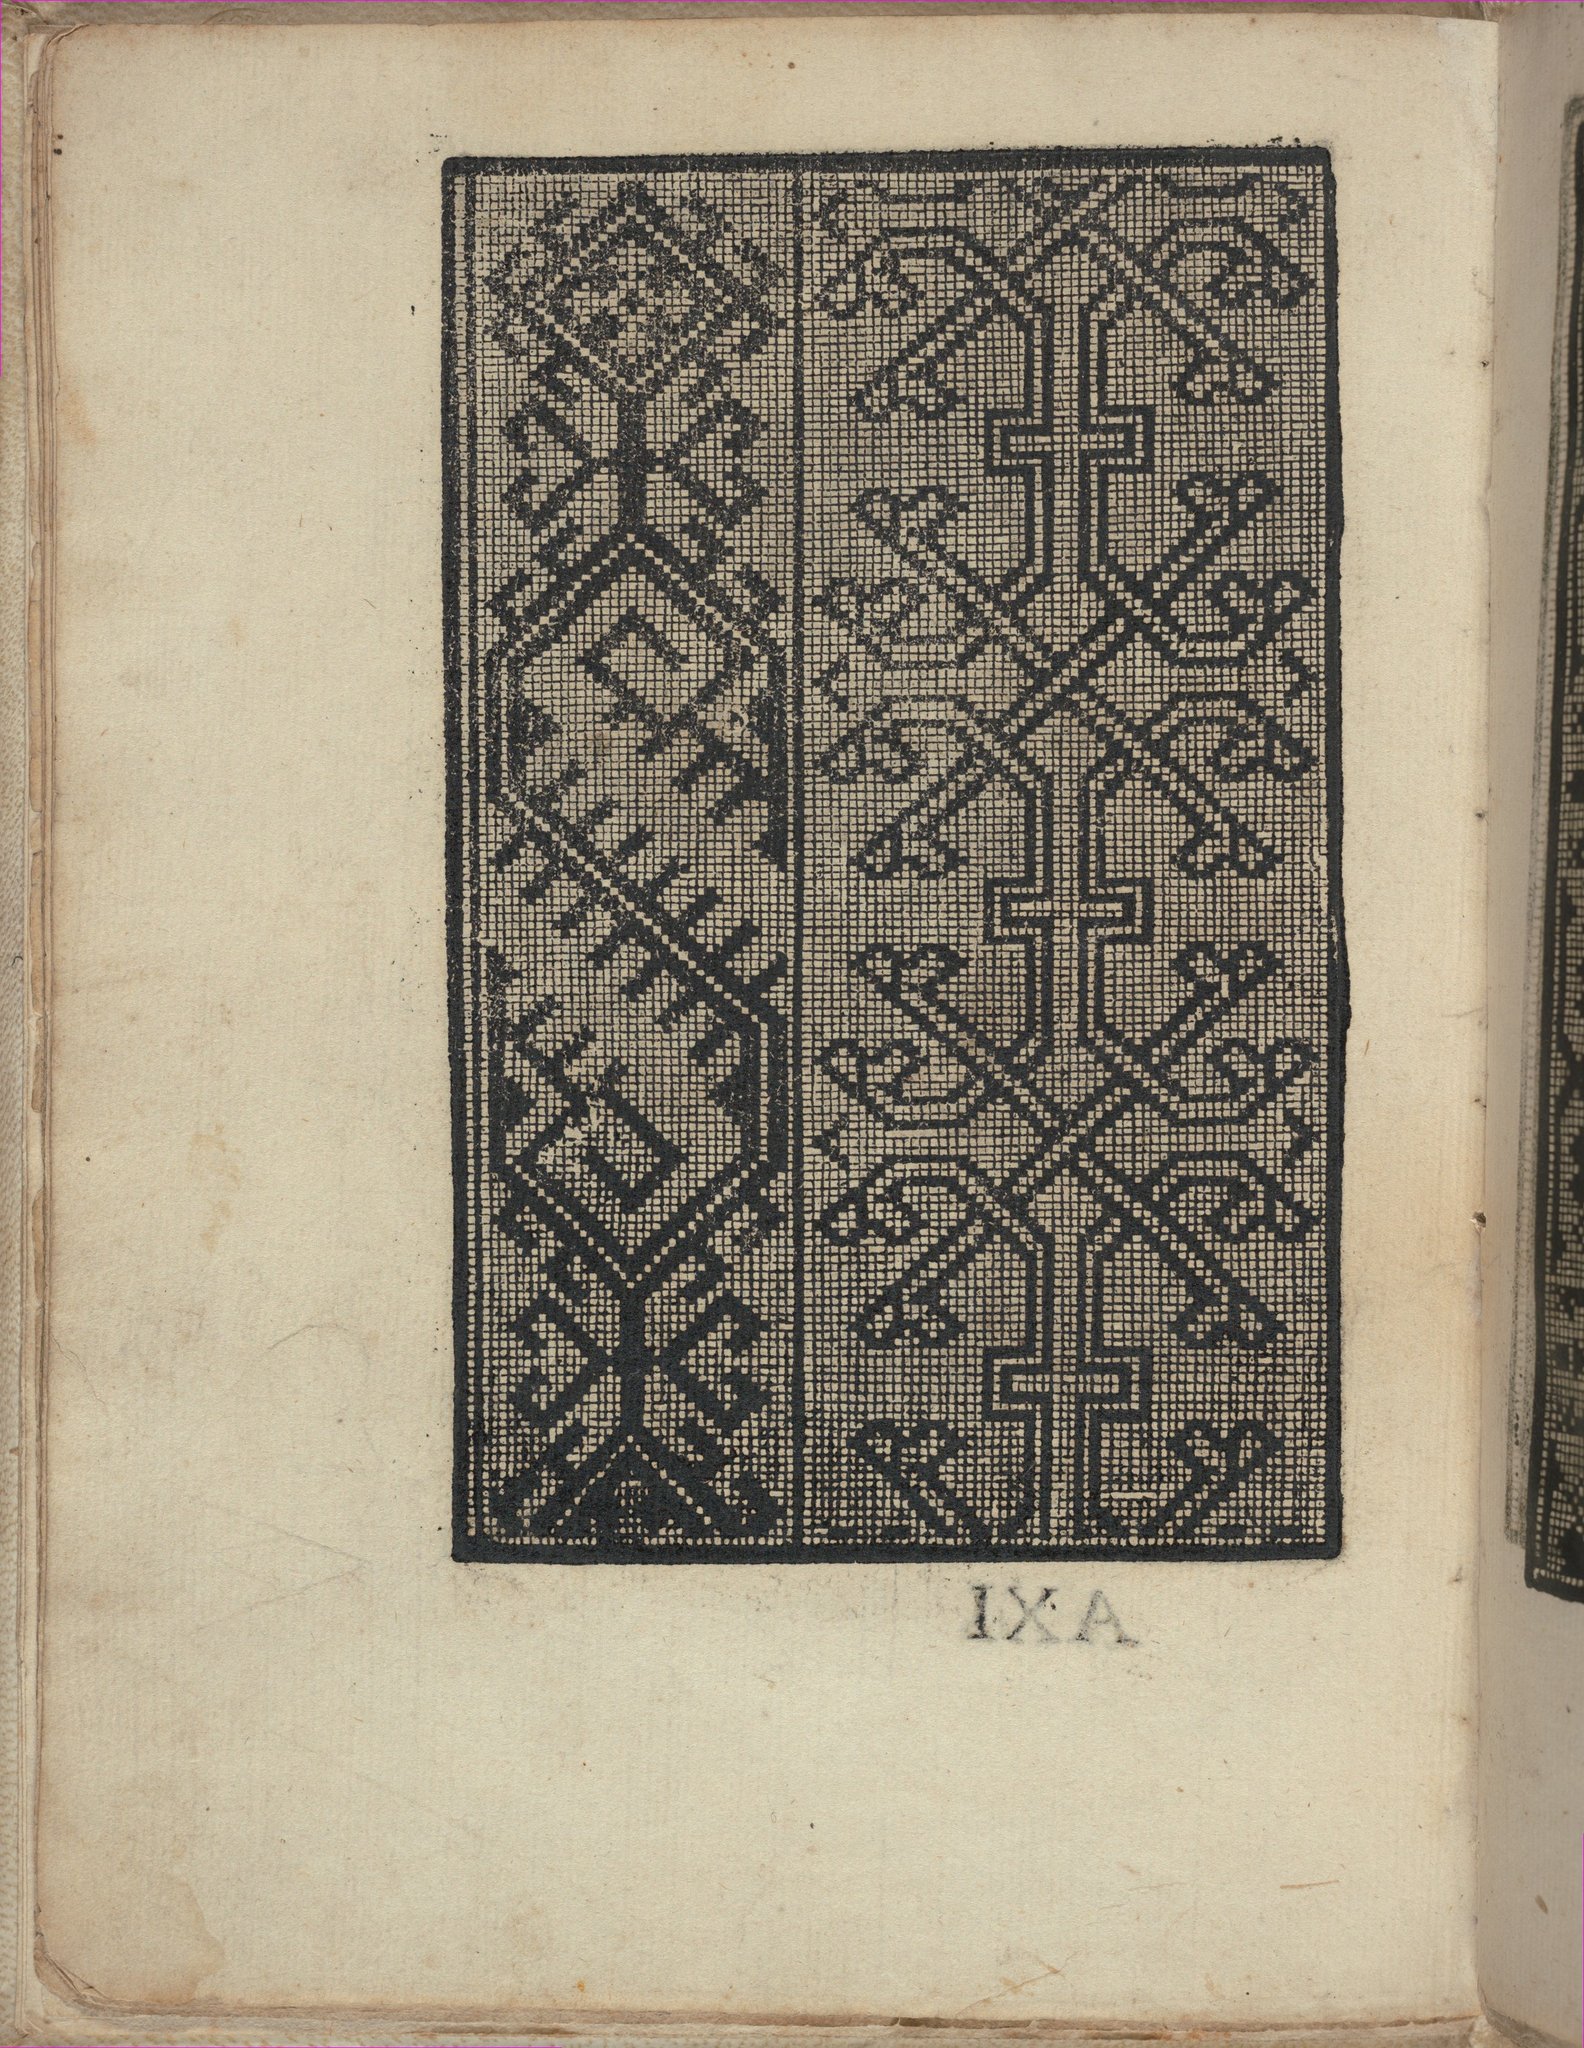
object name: book print ornament architecture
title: Esemplario di Lauori..., page 7 (recto)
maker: giovanni andrea vavassore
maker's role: publisher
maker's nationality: italian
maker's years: 1530-1573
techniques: woodcut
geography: venice